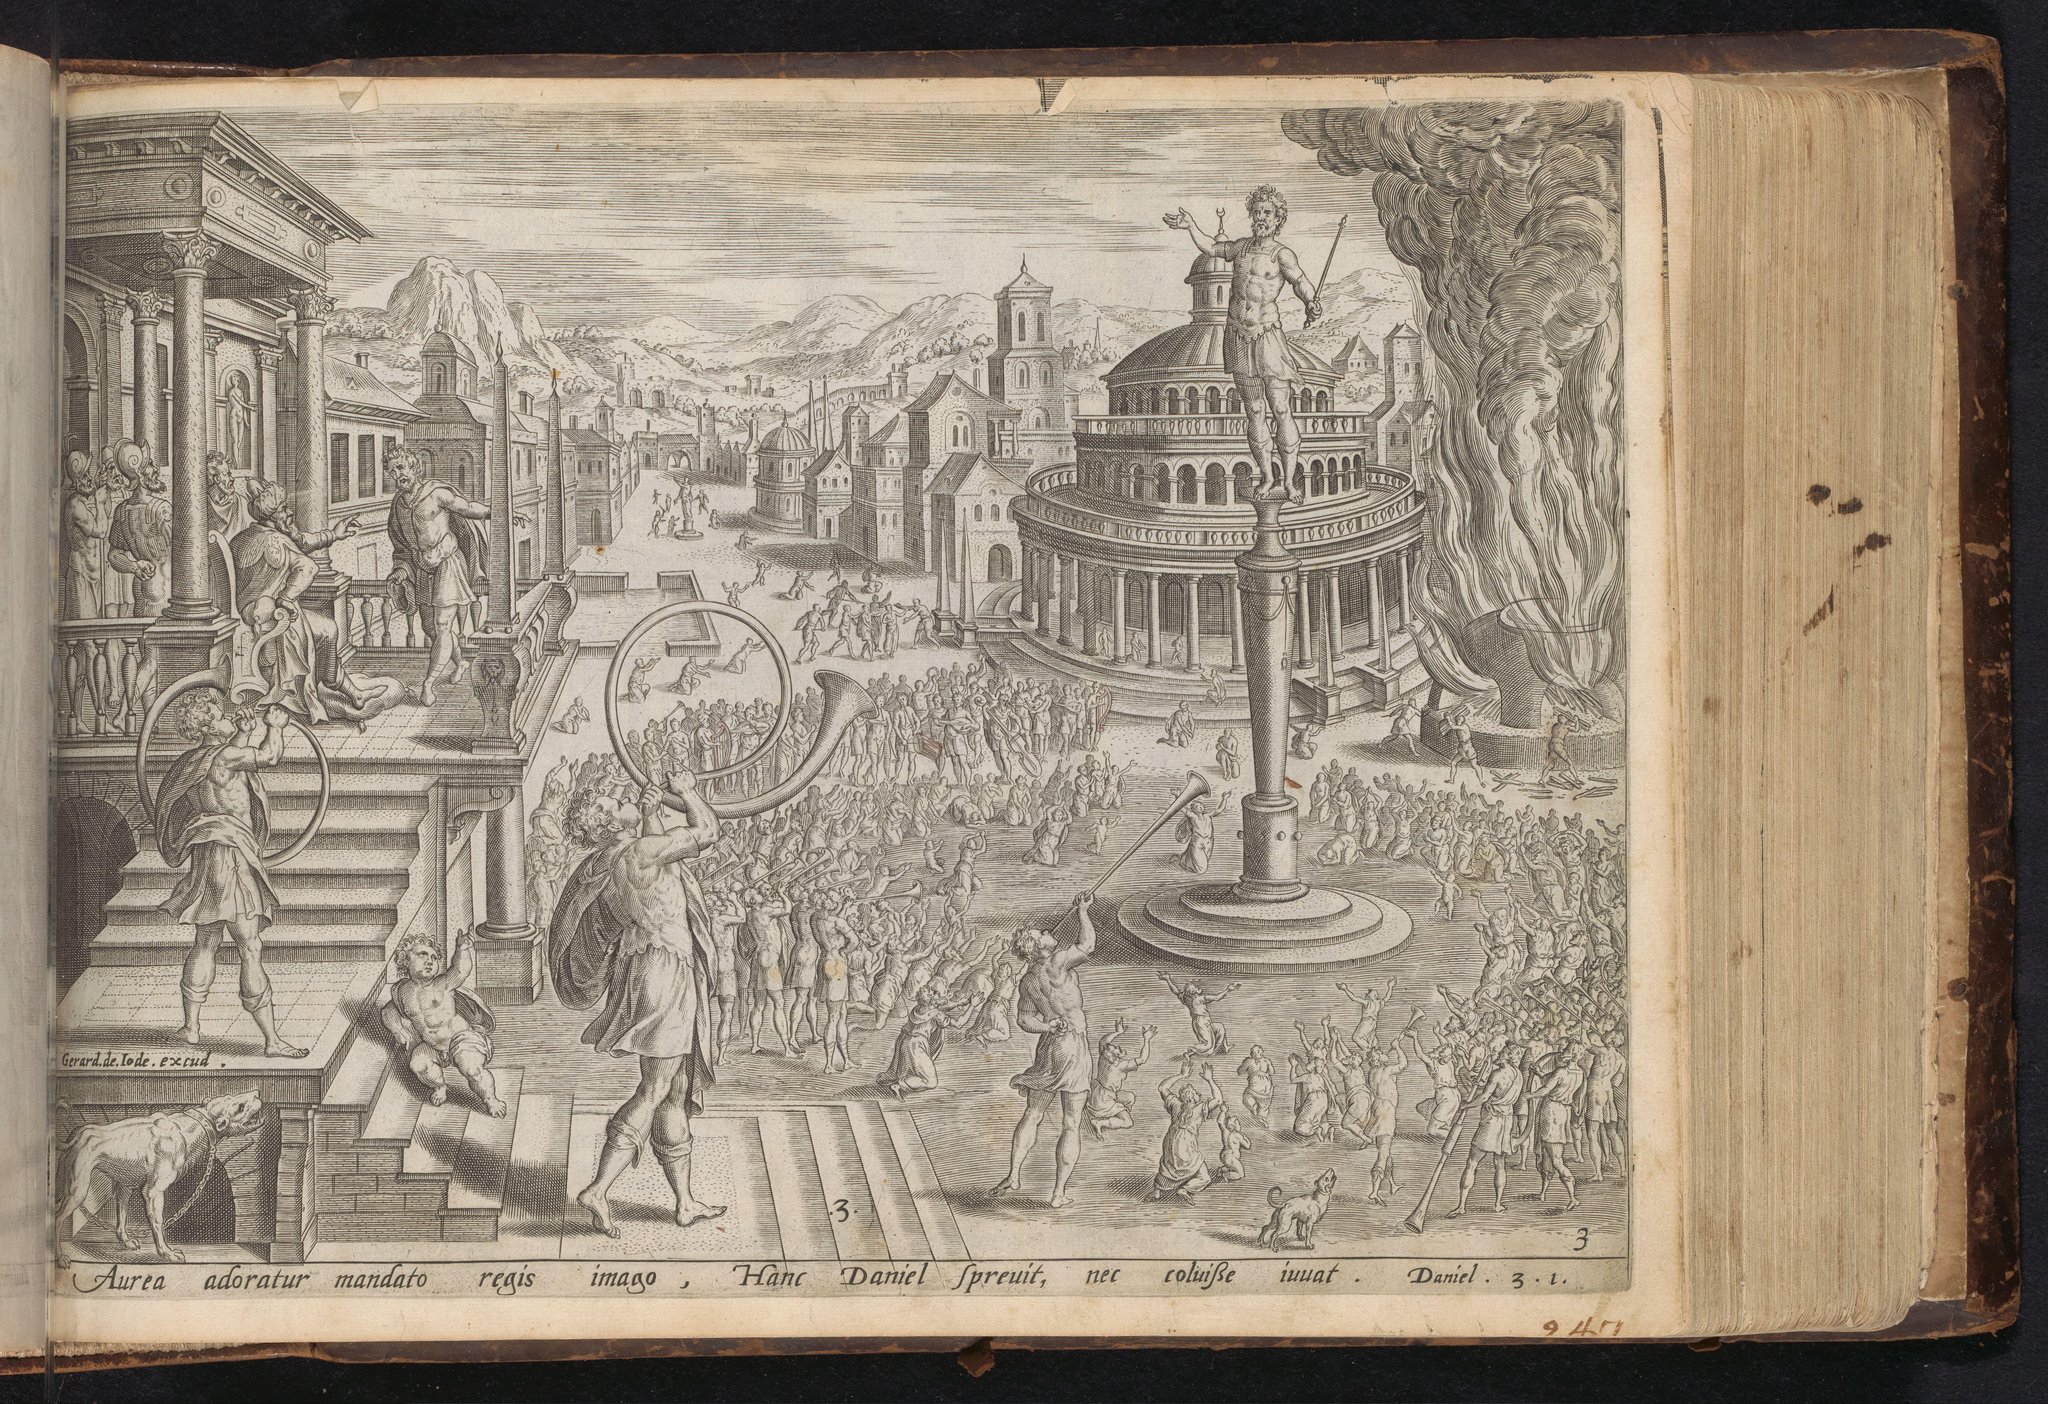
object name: print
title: Den Grooten Figuer-Bibel (...)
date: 1646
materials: paper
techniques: engraving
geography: alkmaar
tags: it is reported to king nebuchadnezzar that shadrach, mesach, and abed-nego do not worship the golden statue, the dedication of the golden statue: in the presence of king nebuchadnezzar, trumpets are blown and all the people surrounding the image fall on their knees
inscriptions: number: ‘247’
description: Koning Nebukadnessar heeft een gouden standbeeld laten oprichten en heeft de opdracht gegeven dat iedereen voor het beeld moet buigen. Bij het geluid van de trompet buigt een menigte voor het beeld. Een man vertelt de koning, links op het balkon, dat Sadrach, Mesach en Abednego weigeren te buigen. De drie mannen worden midden op de achtergrond gevangen genomen. Uiterst rechts wordt een oven opgestookt om een ieder die niet buigt te verbranden. Onder de voorstelling een verwijzing in het Latijn naar de Bijbeltekst in Dan. 3:1. Deze prent maakt deel uit van een album.